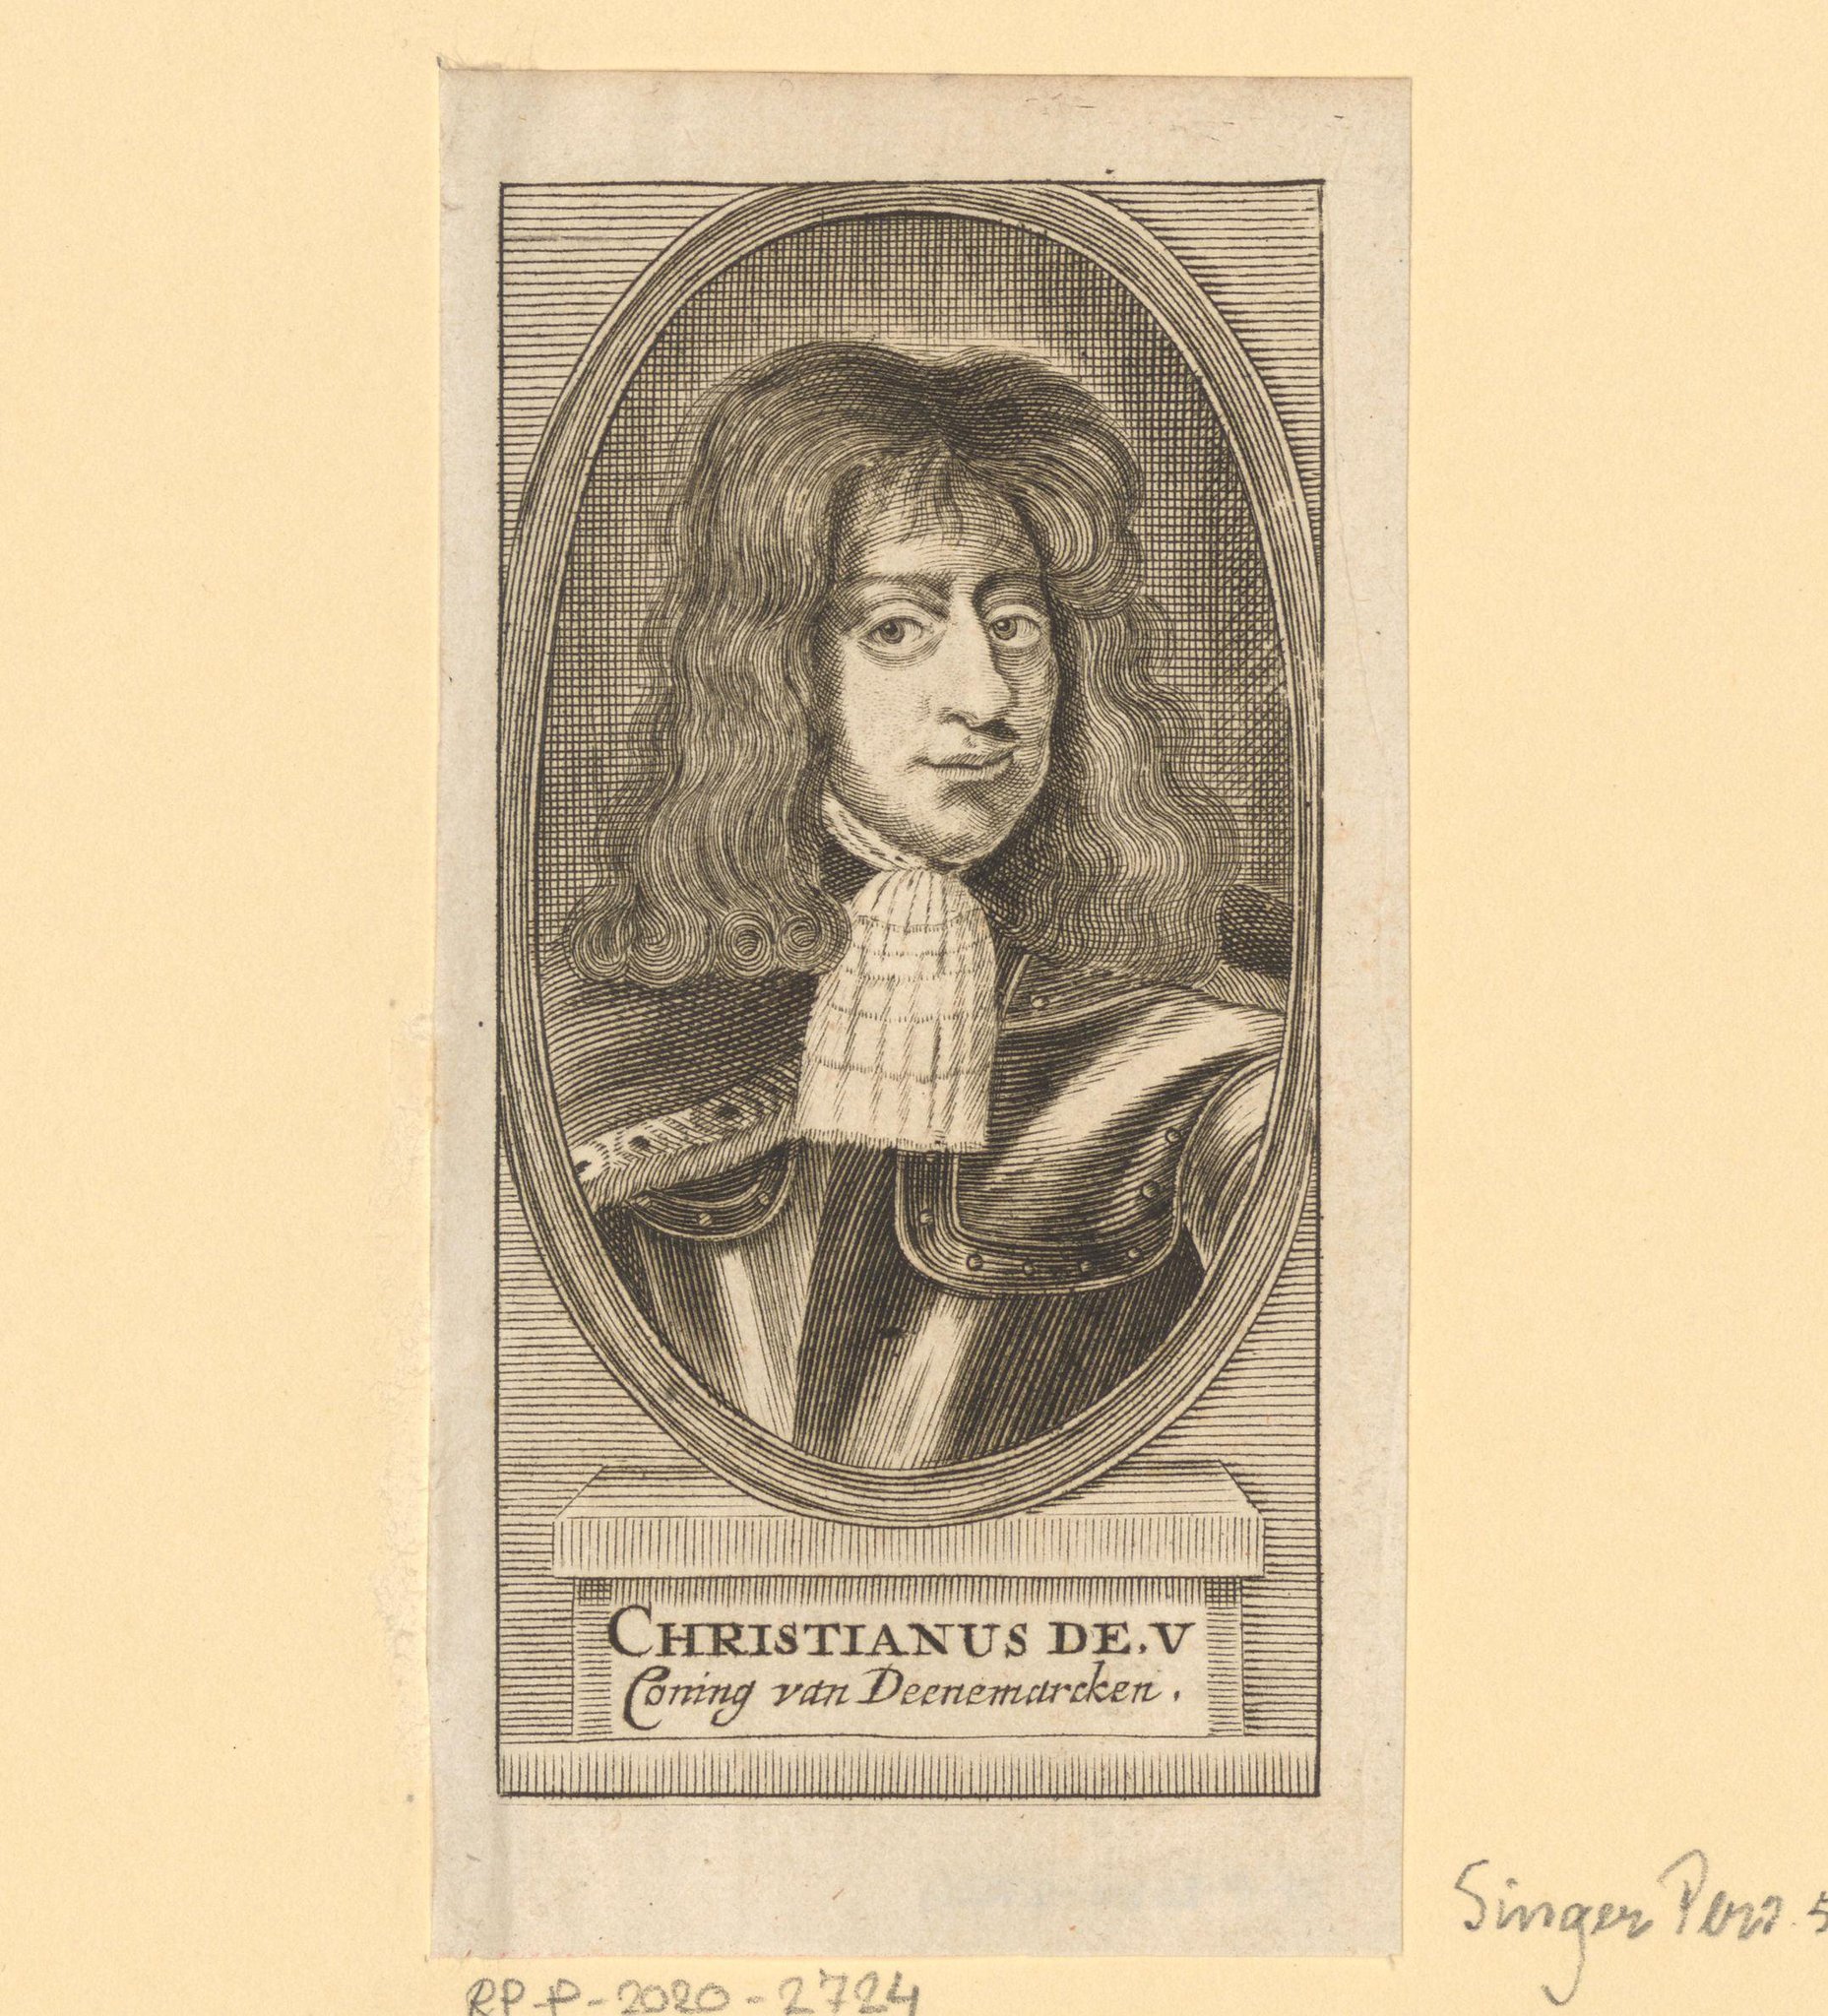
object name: print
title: Portret van Christiaan V, koning van Denemarken en Noorwegen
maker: Anonymous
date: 1670-1725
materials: paper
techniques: engraving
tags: copenhagen (city), historical persons, king